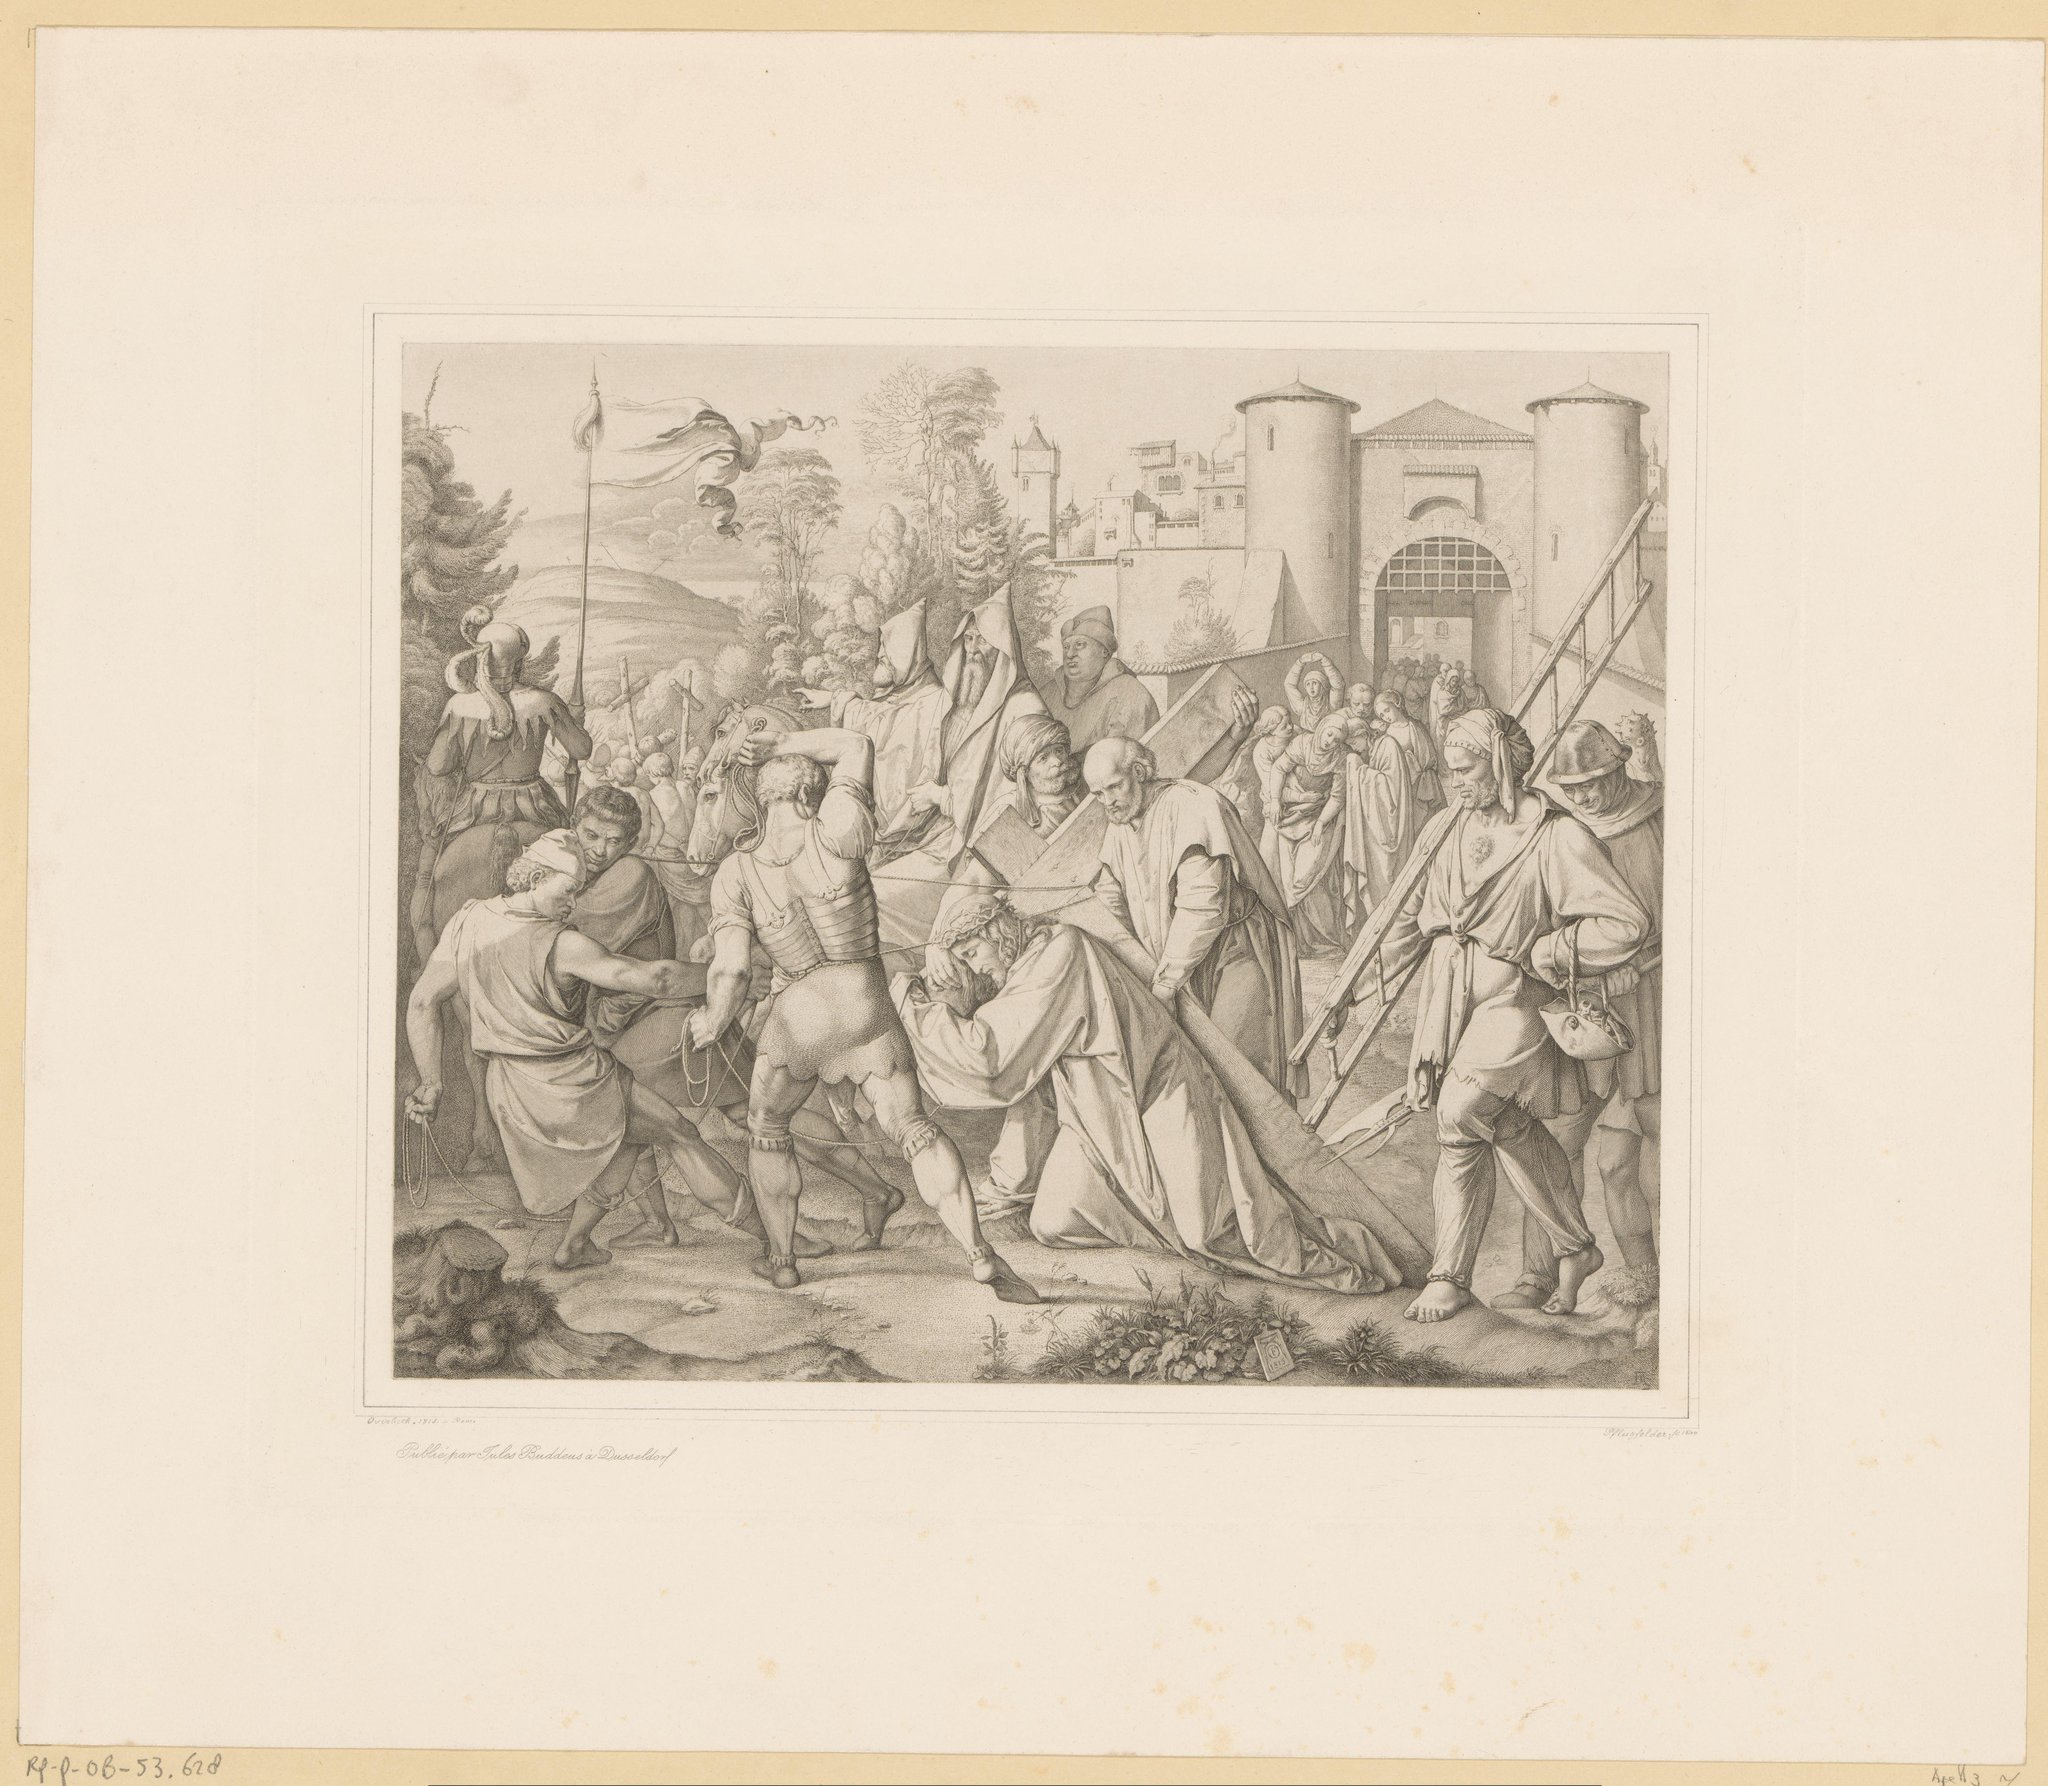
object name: print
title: Kruisdraging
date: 1840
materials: paper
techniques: etching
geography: dusseldorf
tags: carrying of the cross: christ bearing the cross, alone or with the help of others (e.g. simon the cyrenian)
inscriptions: collector's mark: Lugt 12